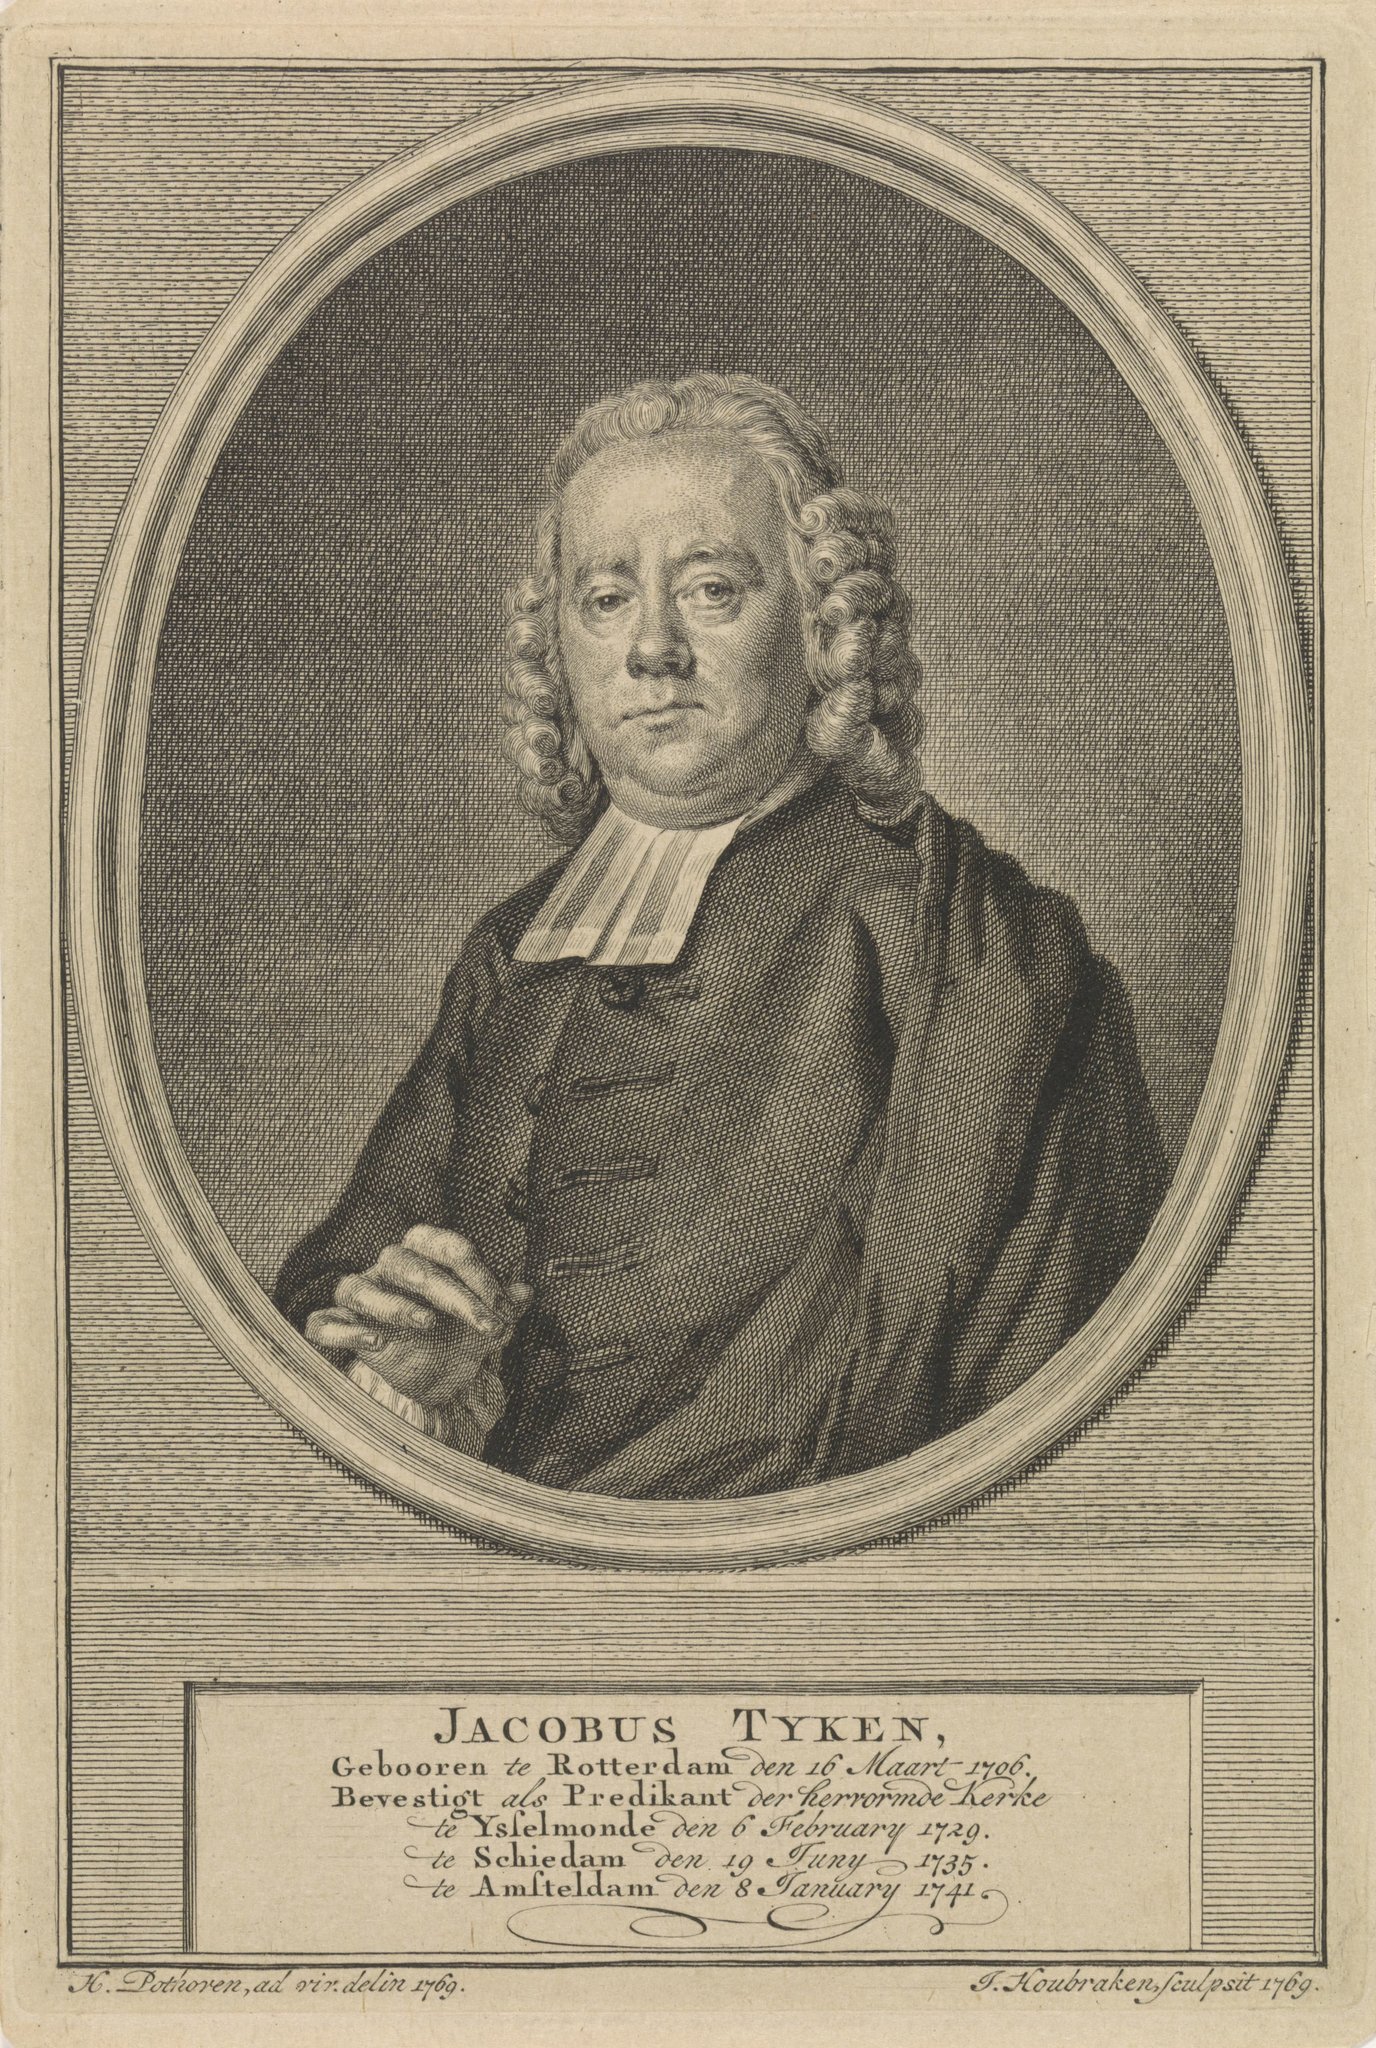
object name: print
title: Portret van Jacobus Tijken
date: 1769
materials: paper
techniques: engraving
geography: amsterdam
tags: rotterdam, amsterdam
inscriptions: collector's mark: Lugt 2228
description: Portret ten halven lijve van Jacobus Tijken in een ovaal medaillon. Het portret rust op een richel waarop zijn naam en gegevens in zes regels in het Nederlands.